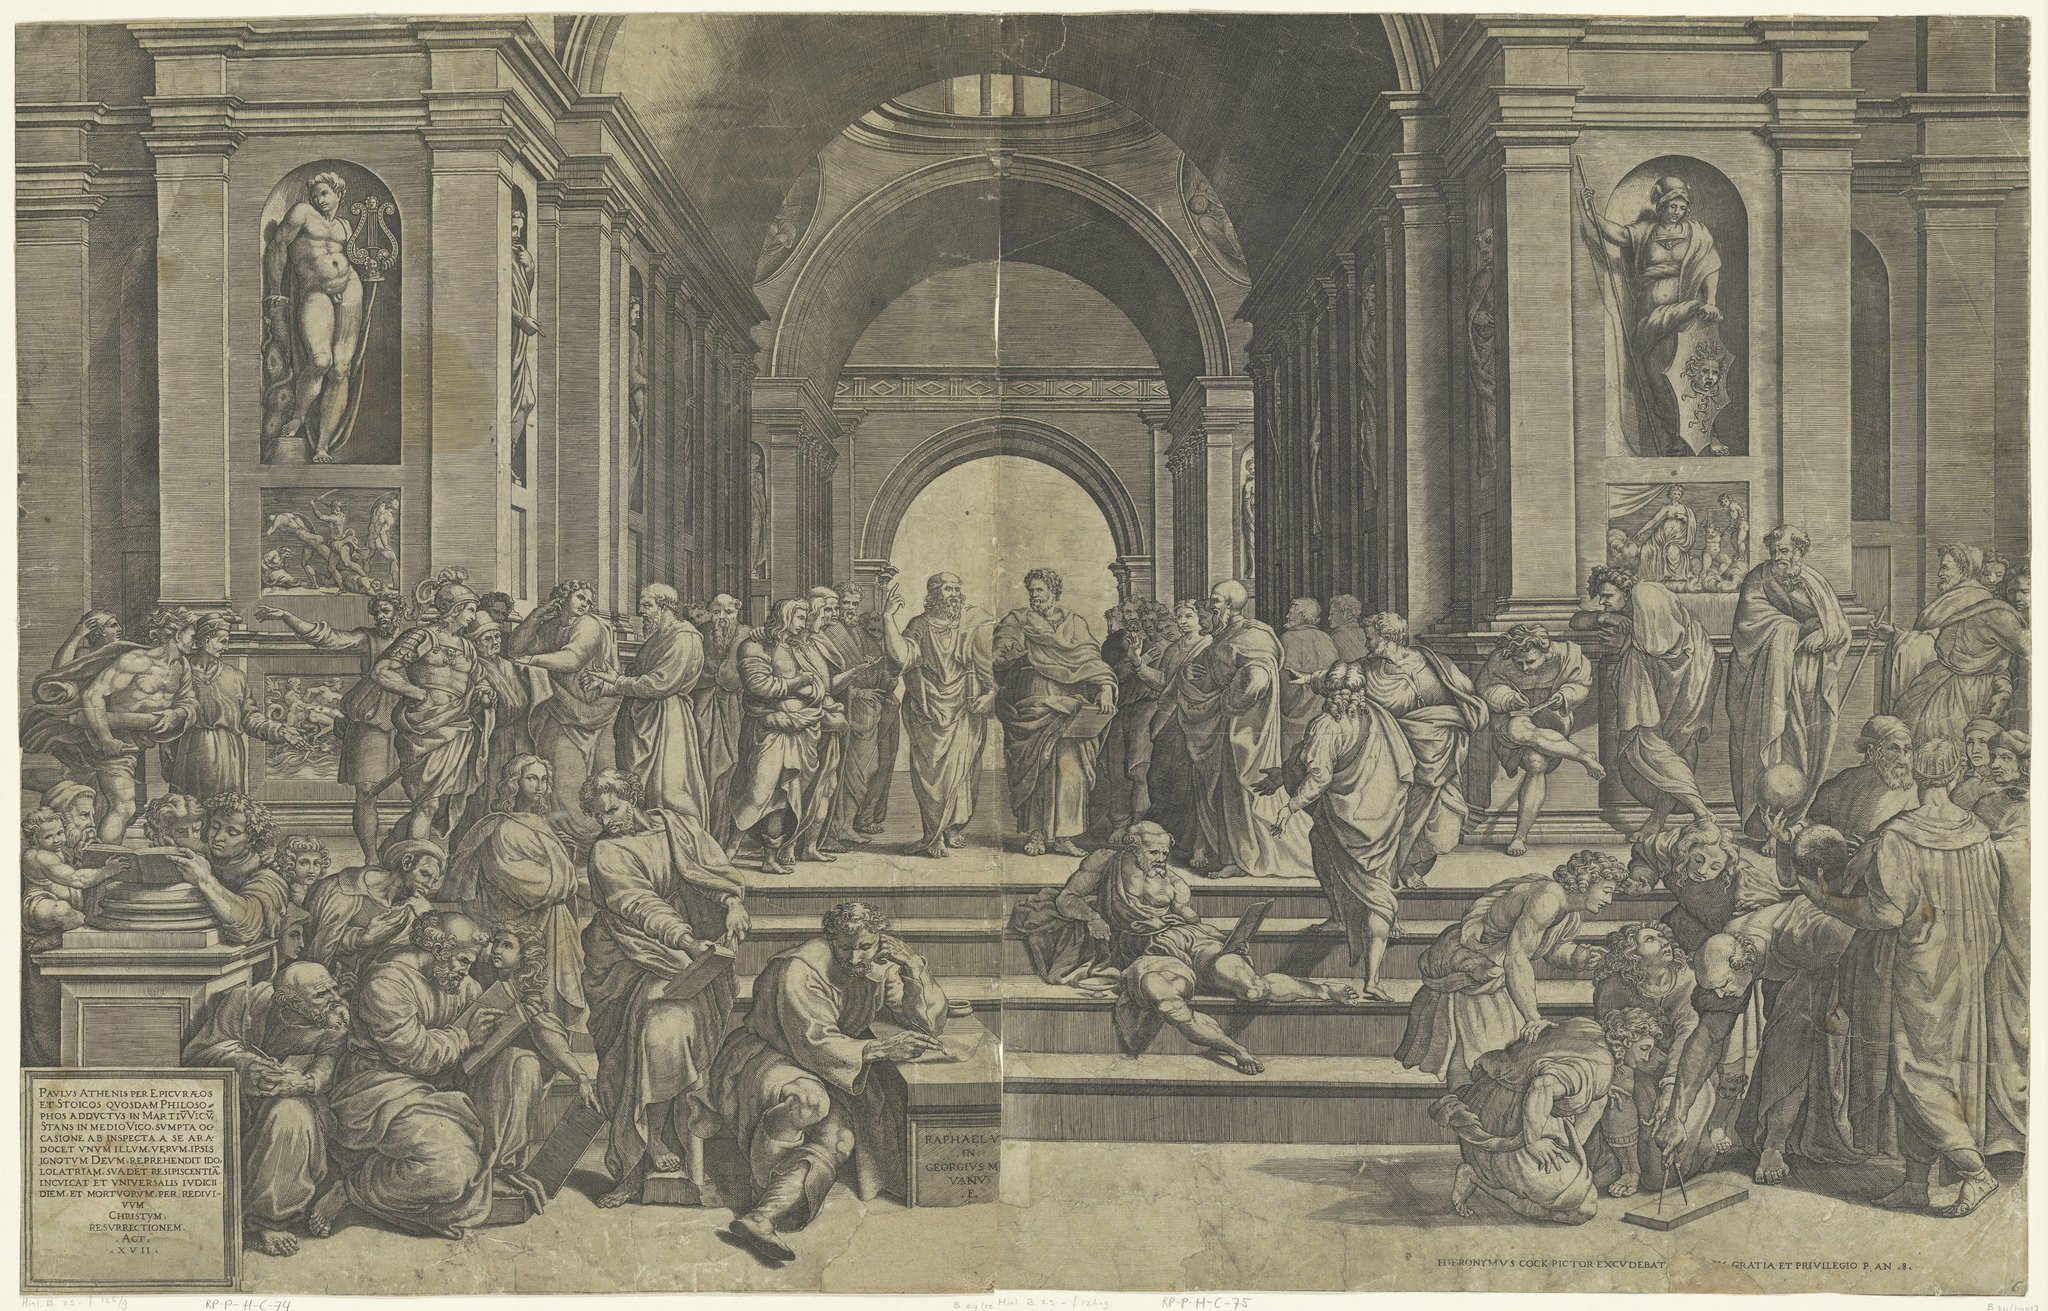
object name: print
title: De School van Athene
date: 1530-1582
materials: paper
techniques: engraving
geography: antwerp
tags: scholar, philosopher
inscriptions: collector's mark: Lugt 10, collector's mark: Lugt 11, collector's mark: ‘Hinloopen’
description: Het fresco 'De School van Athene' door Rafaël in de Stanza della Segnatura in het Apostolisch paleis in het Vaticaan. Het toont een filosofenschool of agora waar beroemde Griekse filosofen en geleerden, zoals Aristoteles, Plato en Socrates, in groepjes staan te praten. Het is een uitbeelding van de filosofie en haar rationele zoektocht naar de Waarheid.